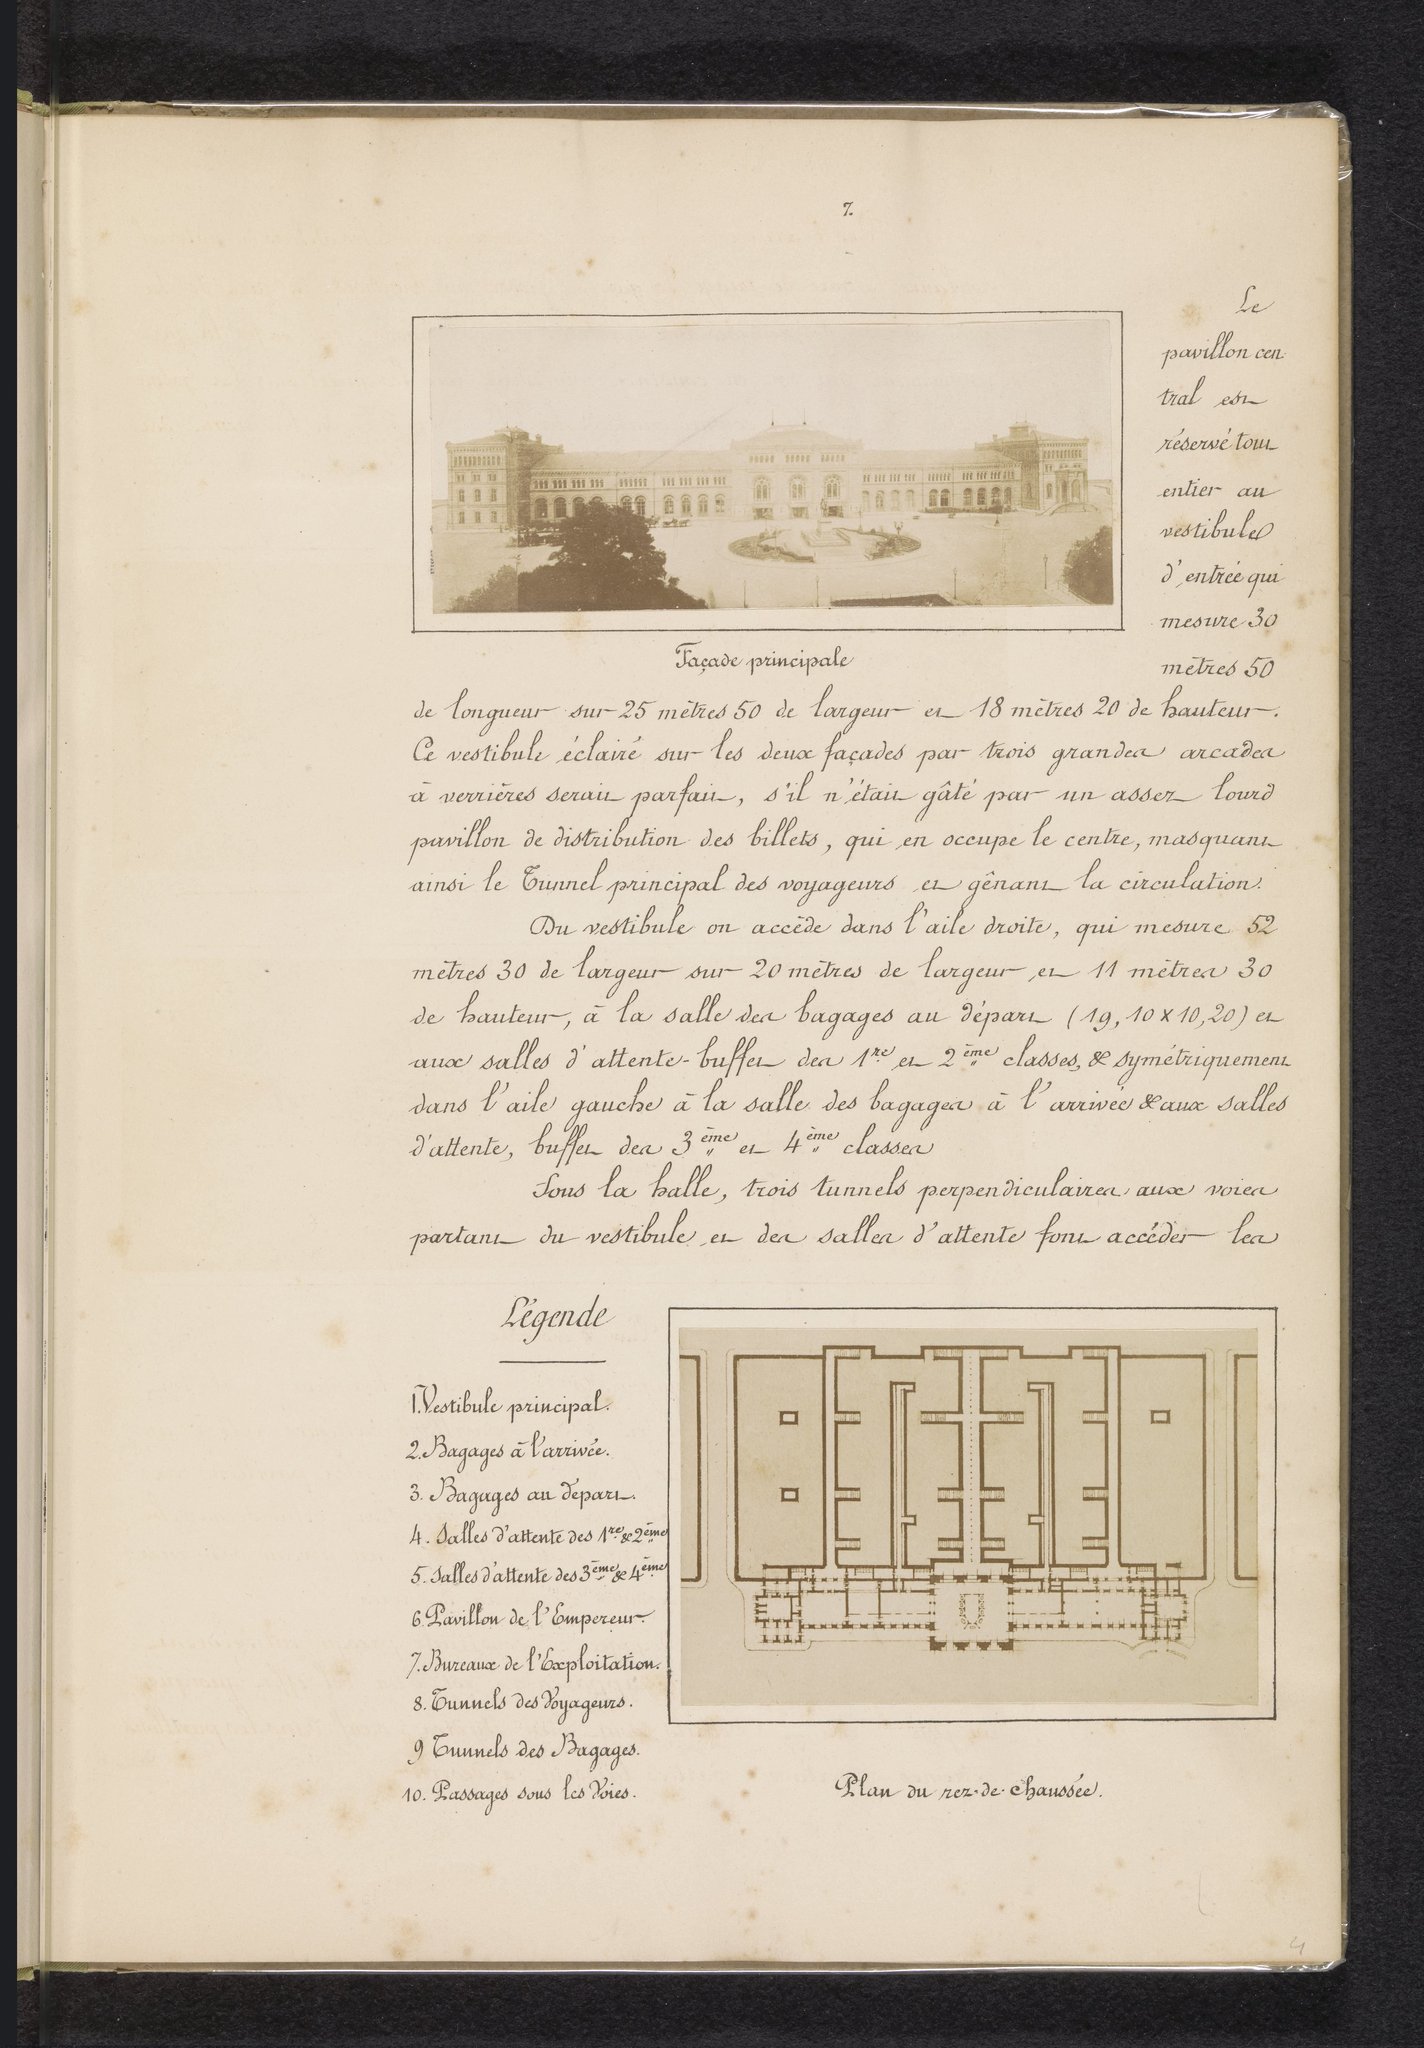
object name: page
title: Gezicht op Hannover Hauptbahnhof en een fotoreproductie van de plattegrond van het station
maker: Anonymous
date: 1874-1884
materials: photographic support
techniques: albumen print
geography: hannover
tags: maps, atlases, railway, train, façade (of house or building), station; shelter (railway, tramway)